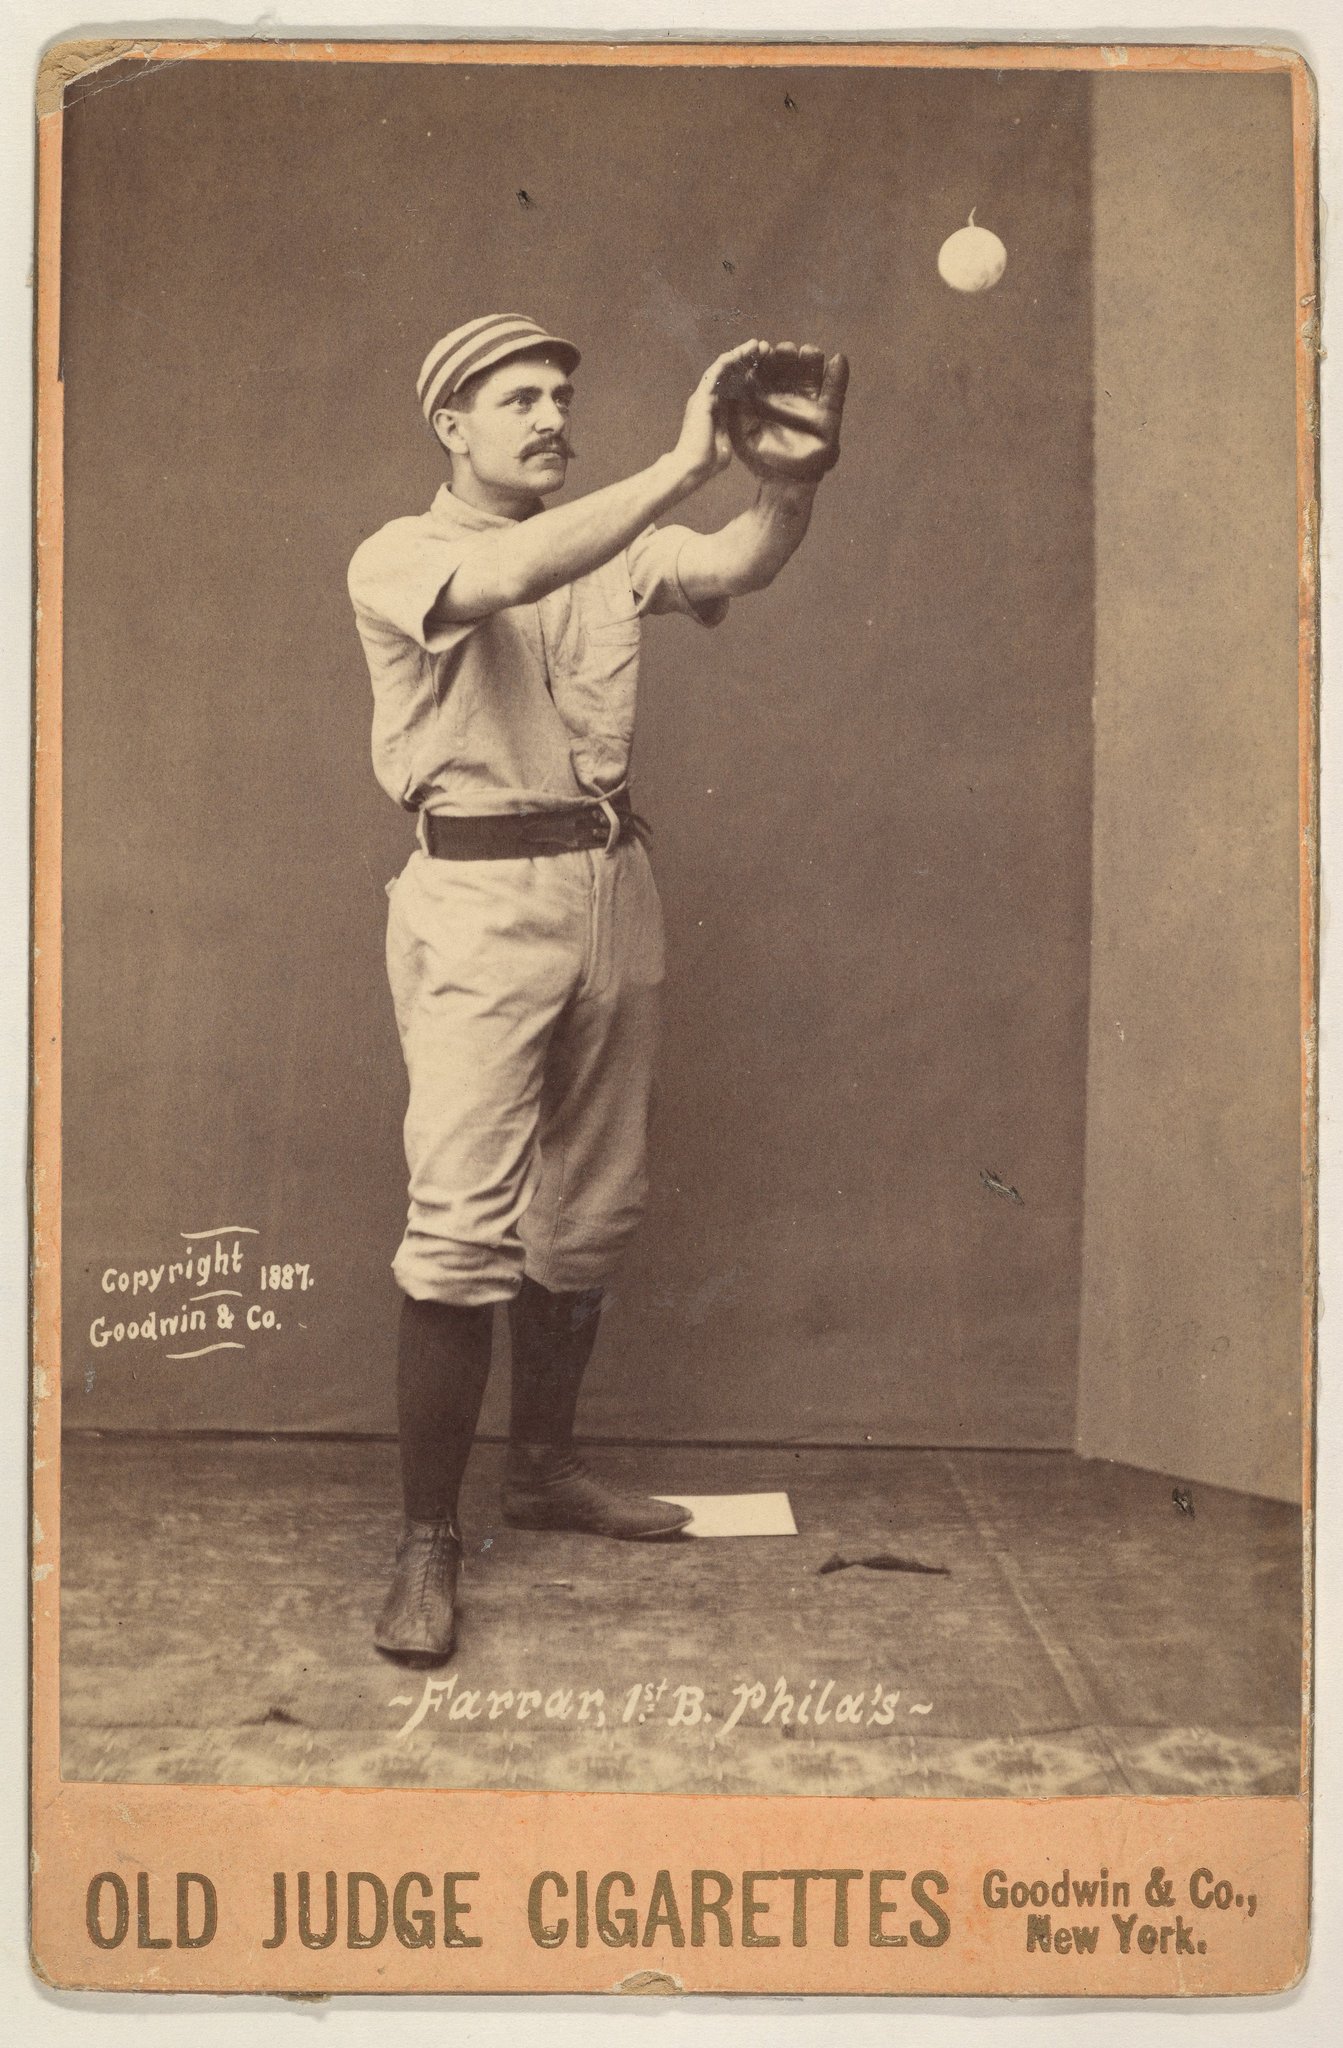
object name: baseball card, photograph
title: Farrar, 1st Base, Philadelphia, from the series Old Judge Cigarettes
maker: goodwin & company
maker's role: publisher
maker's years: 1850-1950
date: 1887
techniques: albumen silver print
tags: men,portraits,baseball,athletes